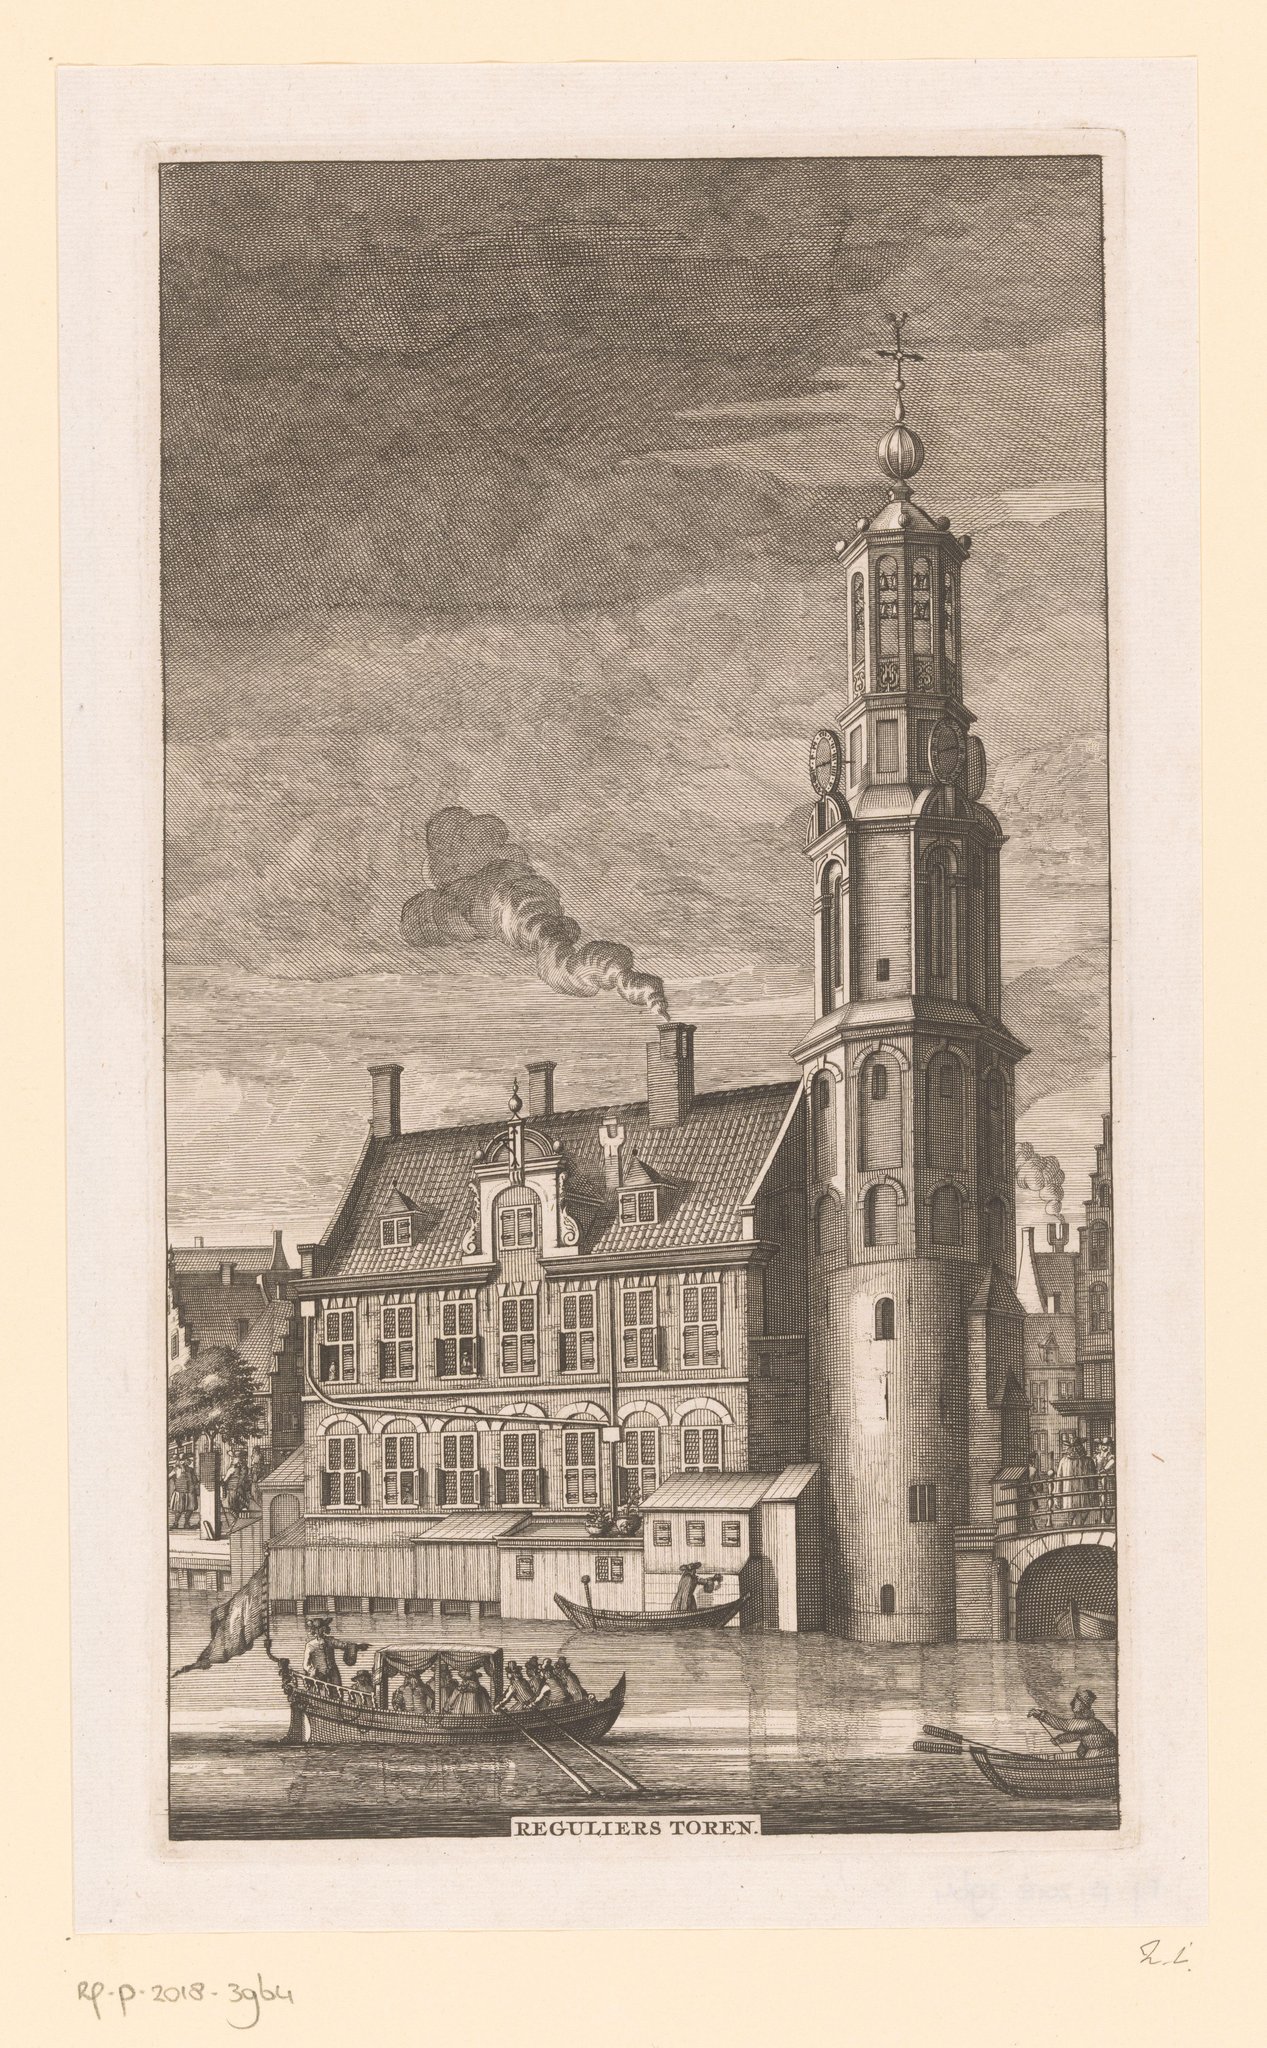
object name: print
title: Gezicht op de Munttoren te Amsterdam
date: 1726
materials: paper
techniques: engraving, etching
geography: amsterdam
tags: tower, clock tower ~ monumental adornment, rowing-boat, canoe, etc., bridge in city across river, canal, etc.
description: Prent uit: Commelin, Caspar. Beschryvinge van Amsterdam (...). 2 dln. Amsterdam: Andries van Damme et al., 1726, tweede druk, dl. 2, p. 700-701.